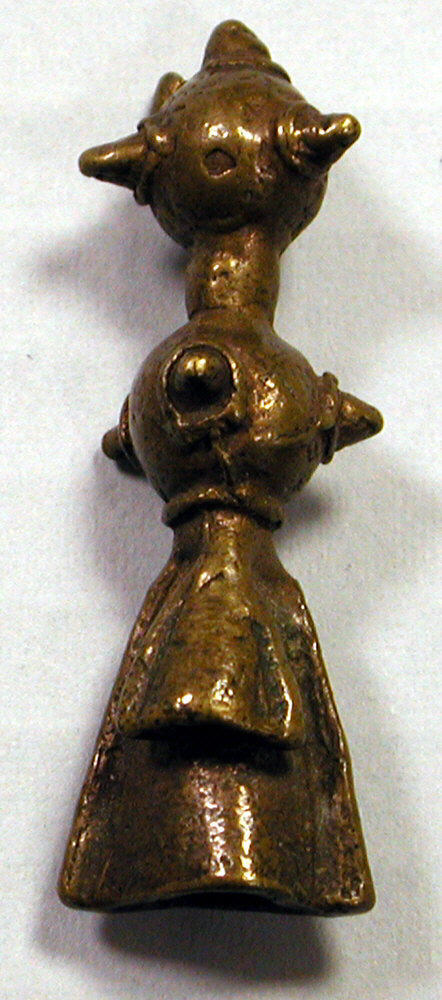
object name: weight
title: Gold Weight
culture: akan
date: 1701-1900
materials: brass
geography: ghana